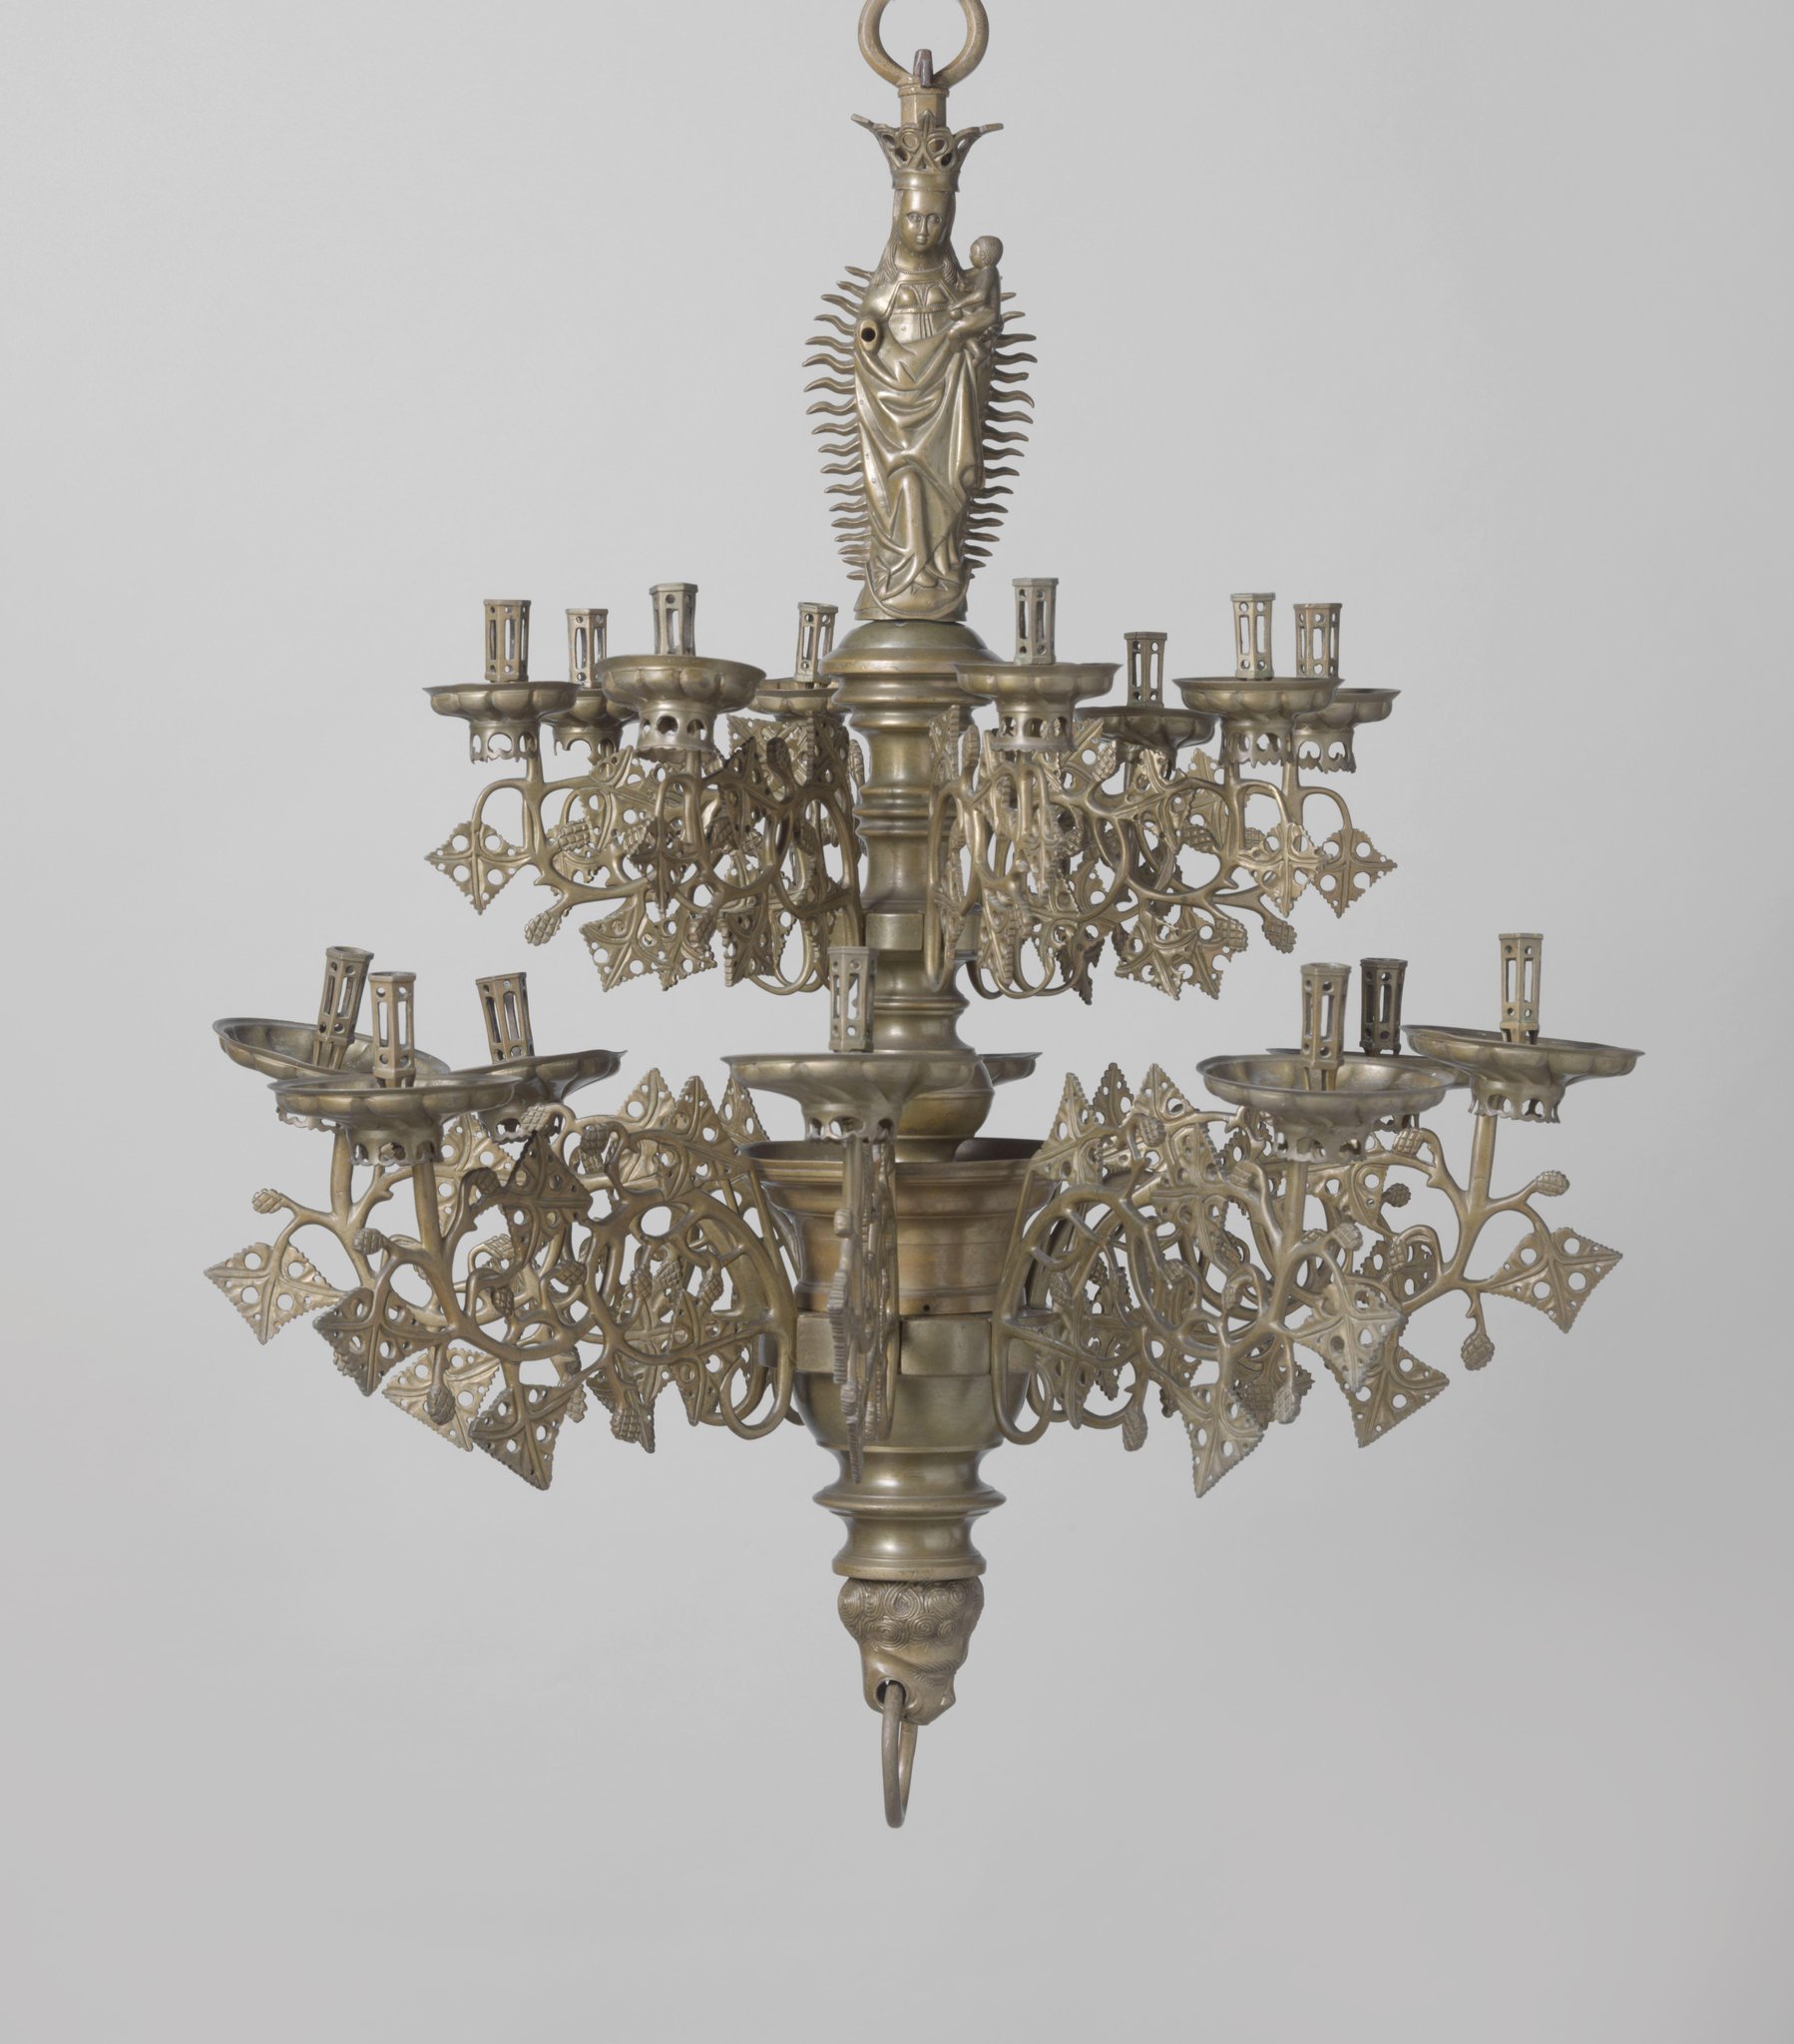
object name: chandelier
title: Arm met kaarsenhouder van kaarsenkroon van twee hoogten met ieder acht armen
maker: Anonymous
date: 1525-1550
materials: brass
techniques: casting, screwed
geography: southern netherlands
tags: vine-tendril, leaf, mary standing (or half-length), the christ-child sitting on her arm (christ-child to mary's left)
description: Kaarsenarm behorende bij een kaarsenkroon van twee hoogten met Mariafiguur bovenaan. De arm is twee maal gebogen en is versierd met negen druiventrossen en vijf wingerdbladeren. De ronde vetvanger is aan de onderkant versierd met visblaasmotieven en heeft naar het midden toe een naar beneden uitstekende rand van kruisbloemen, die de plaatsing op de arm maskeert. De kaarsenhouder is zesvlakkig, opengewerkt, geplaatst op drie verticale stijlen, overgaande in een uitsteeksel met schroefdraad. Dit is de tweede arm van de onderste ring, genummerd met 2 ronde punten. De kaarsenhouder is ongenummerd.